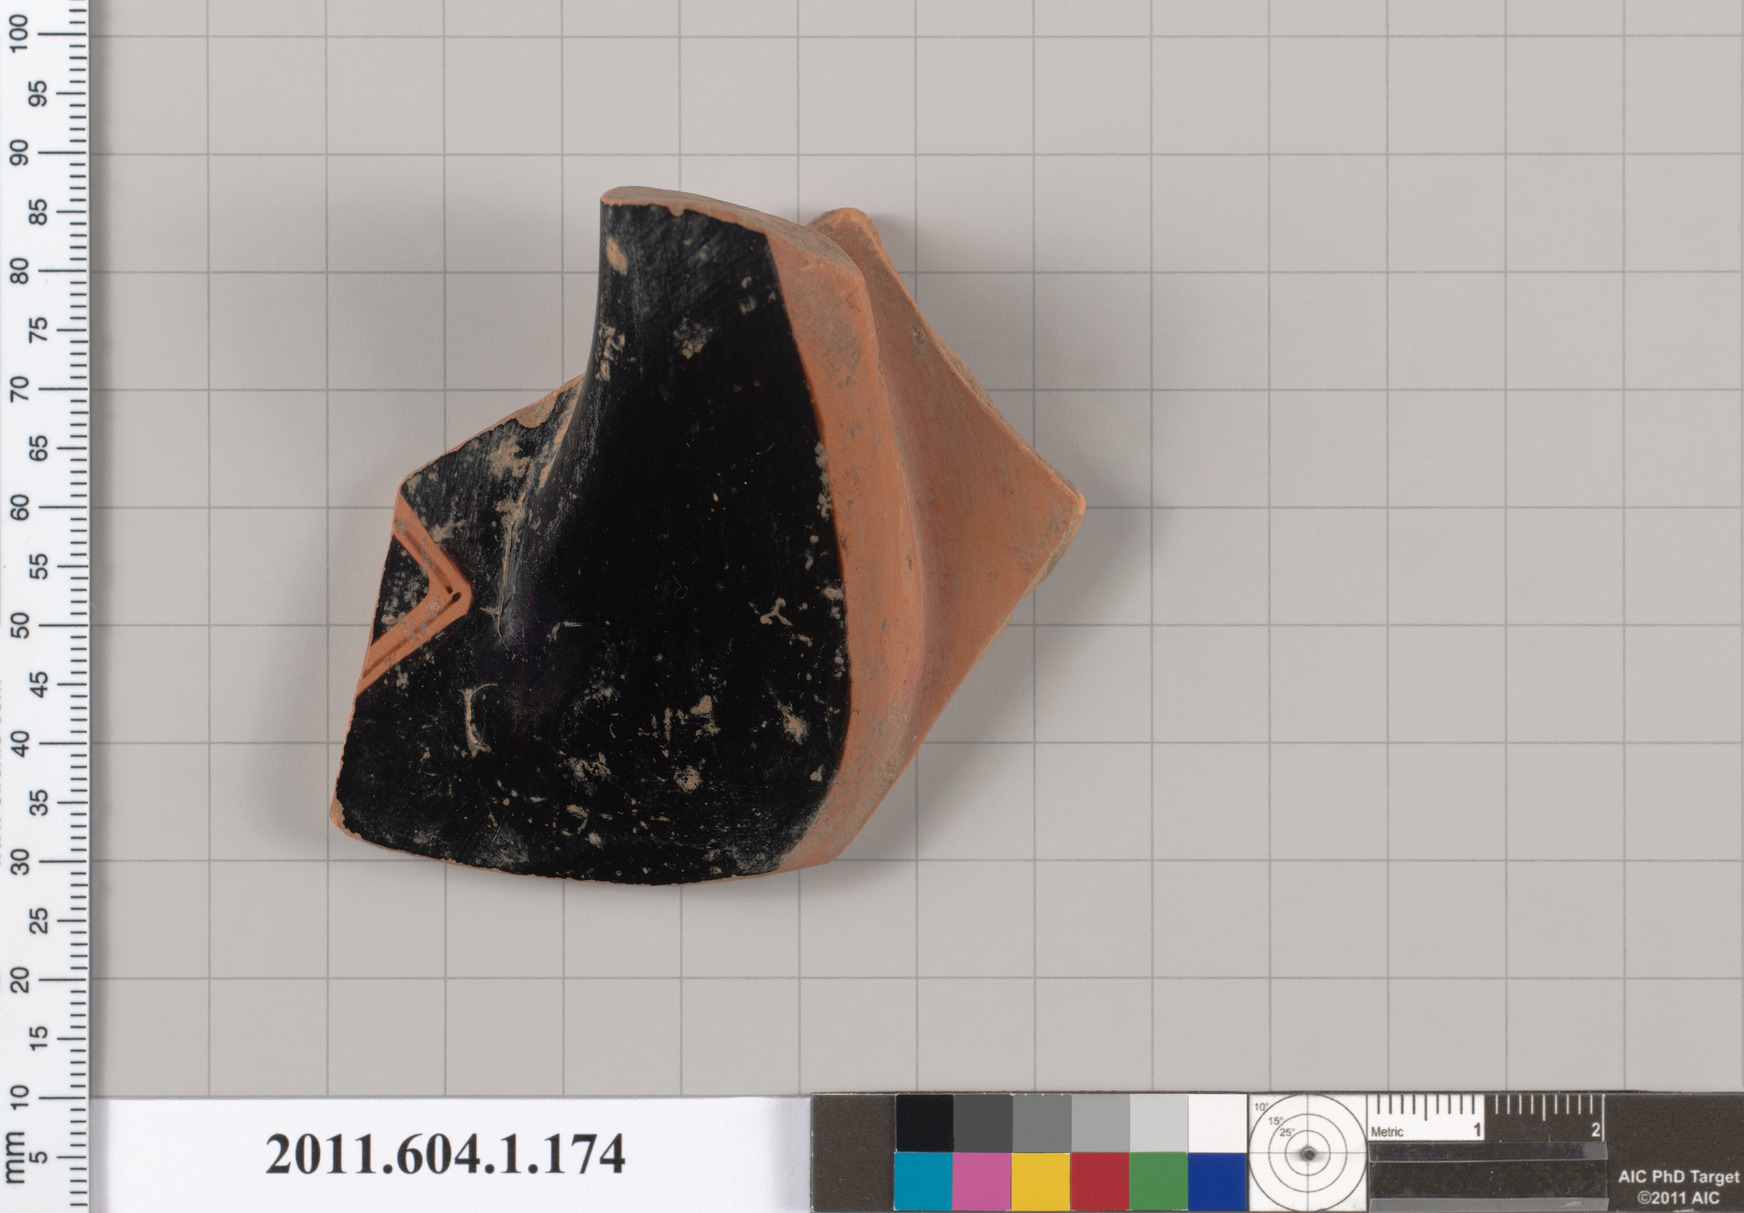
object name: kylix fragment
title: Terracotta fragment of a kylix (drinking cup)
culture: greek, attic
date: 470-450 BCE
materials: terracotta